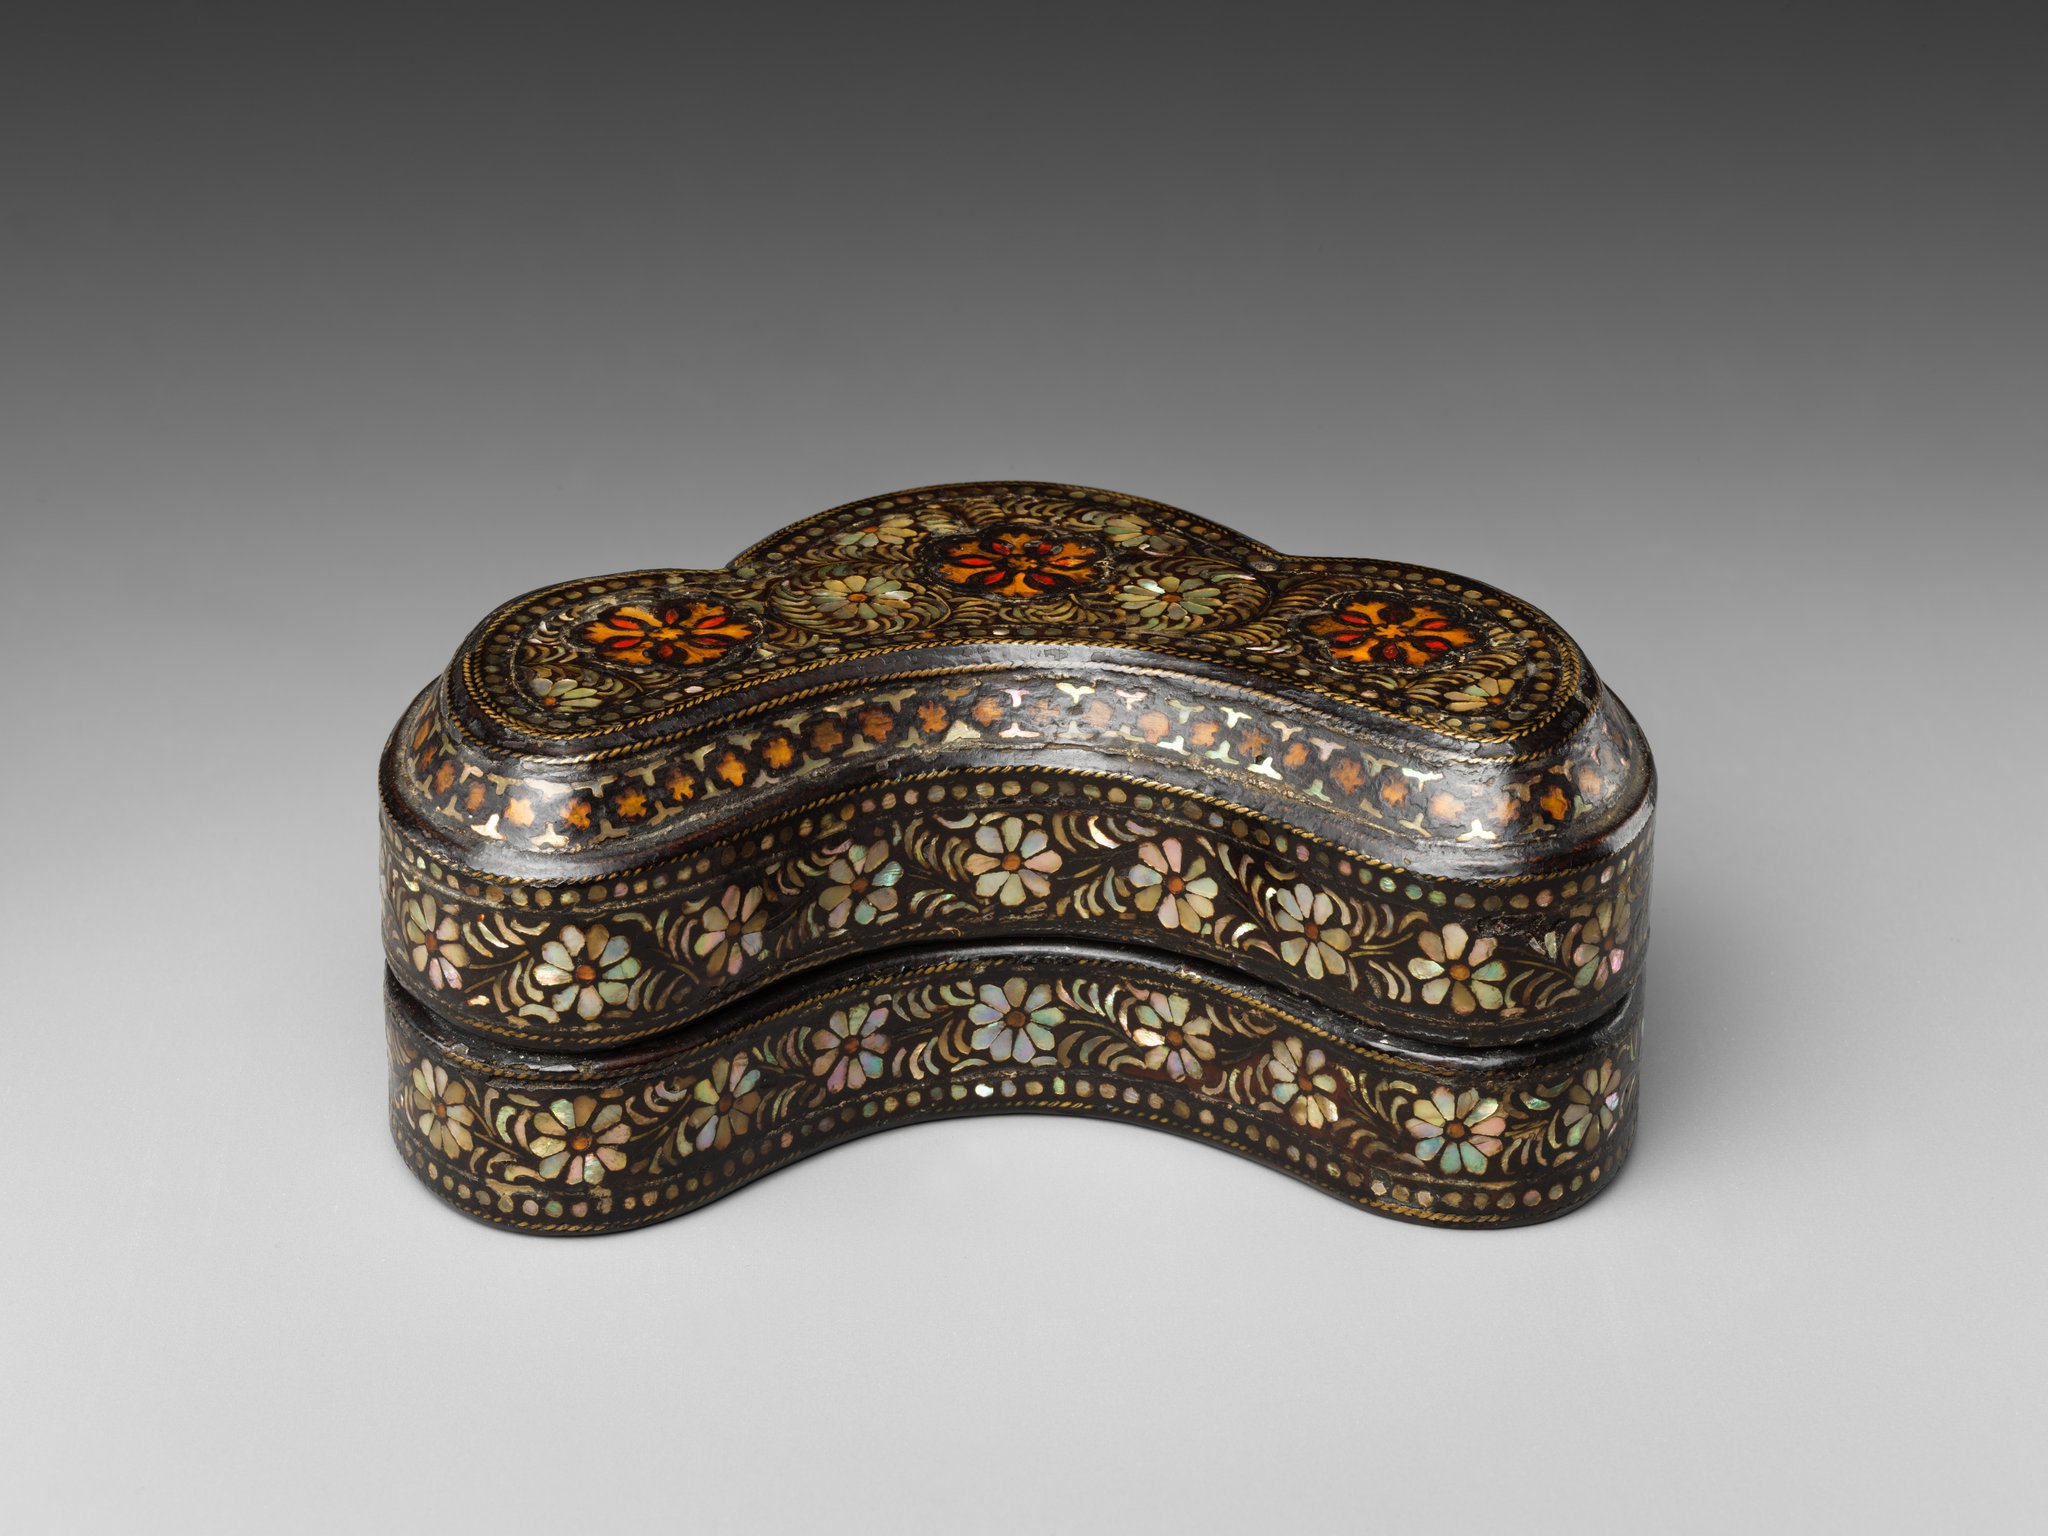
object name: covered box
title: Trefoil-shaped covered box with decoration of chrysanthemums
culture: korean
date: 1101-1200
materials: brass, lacquer, mother of pearl, pigment, shell, metal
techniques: inlay